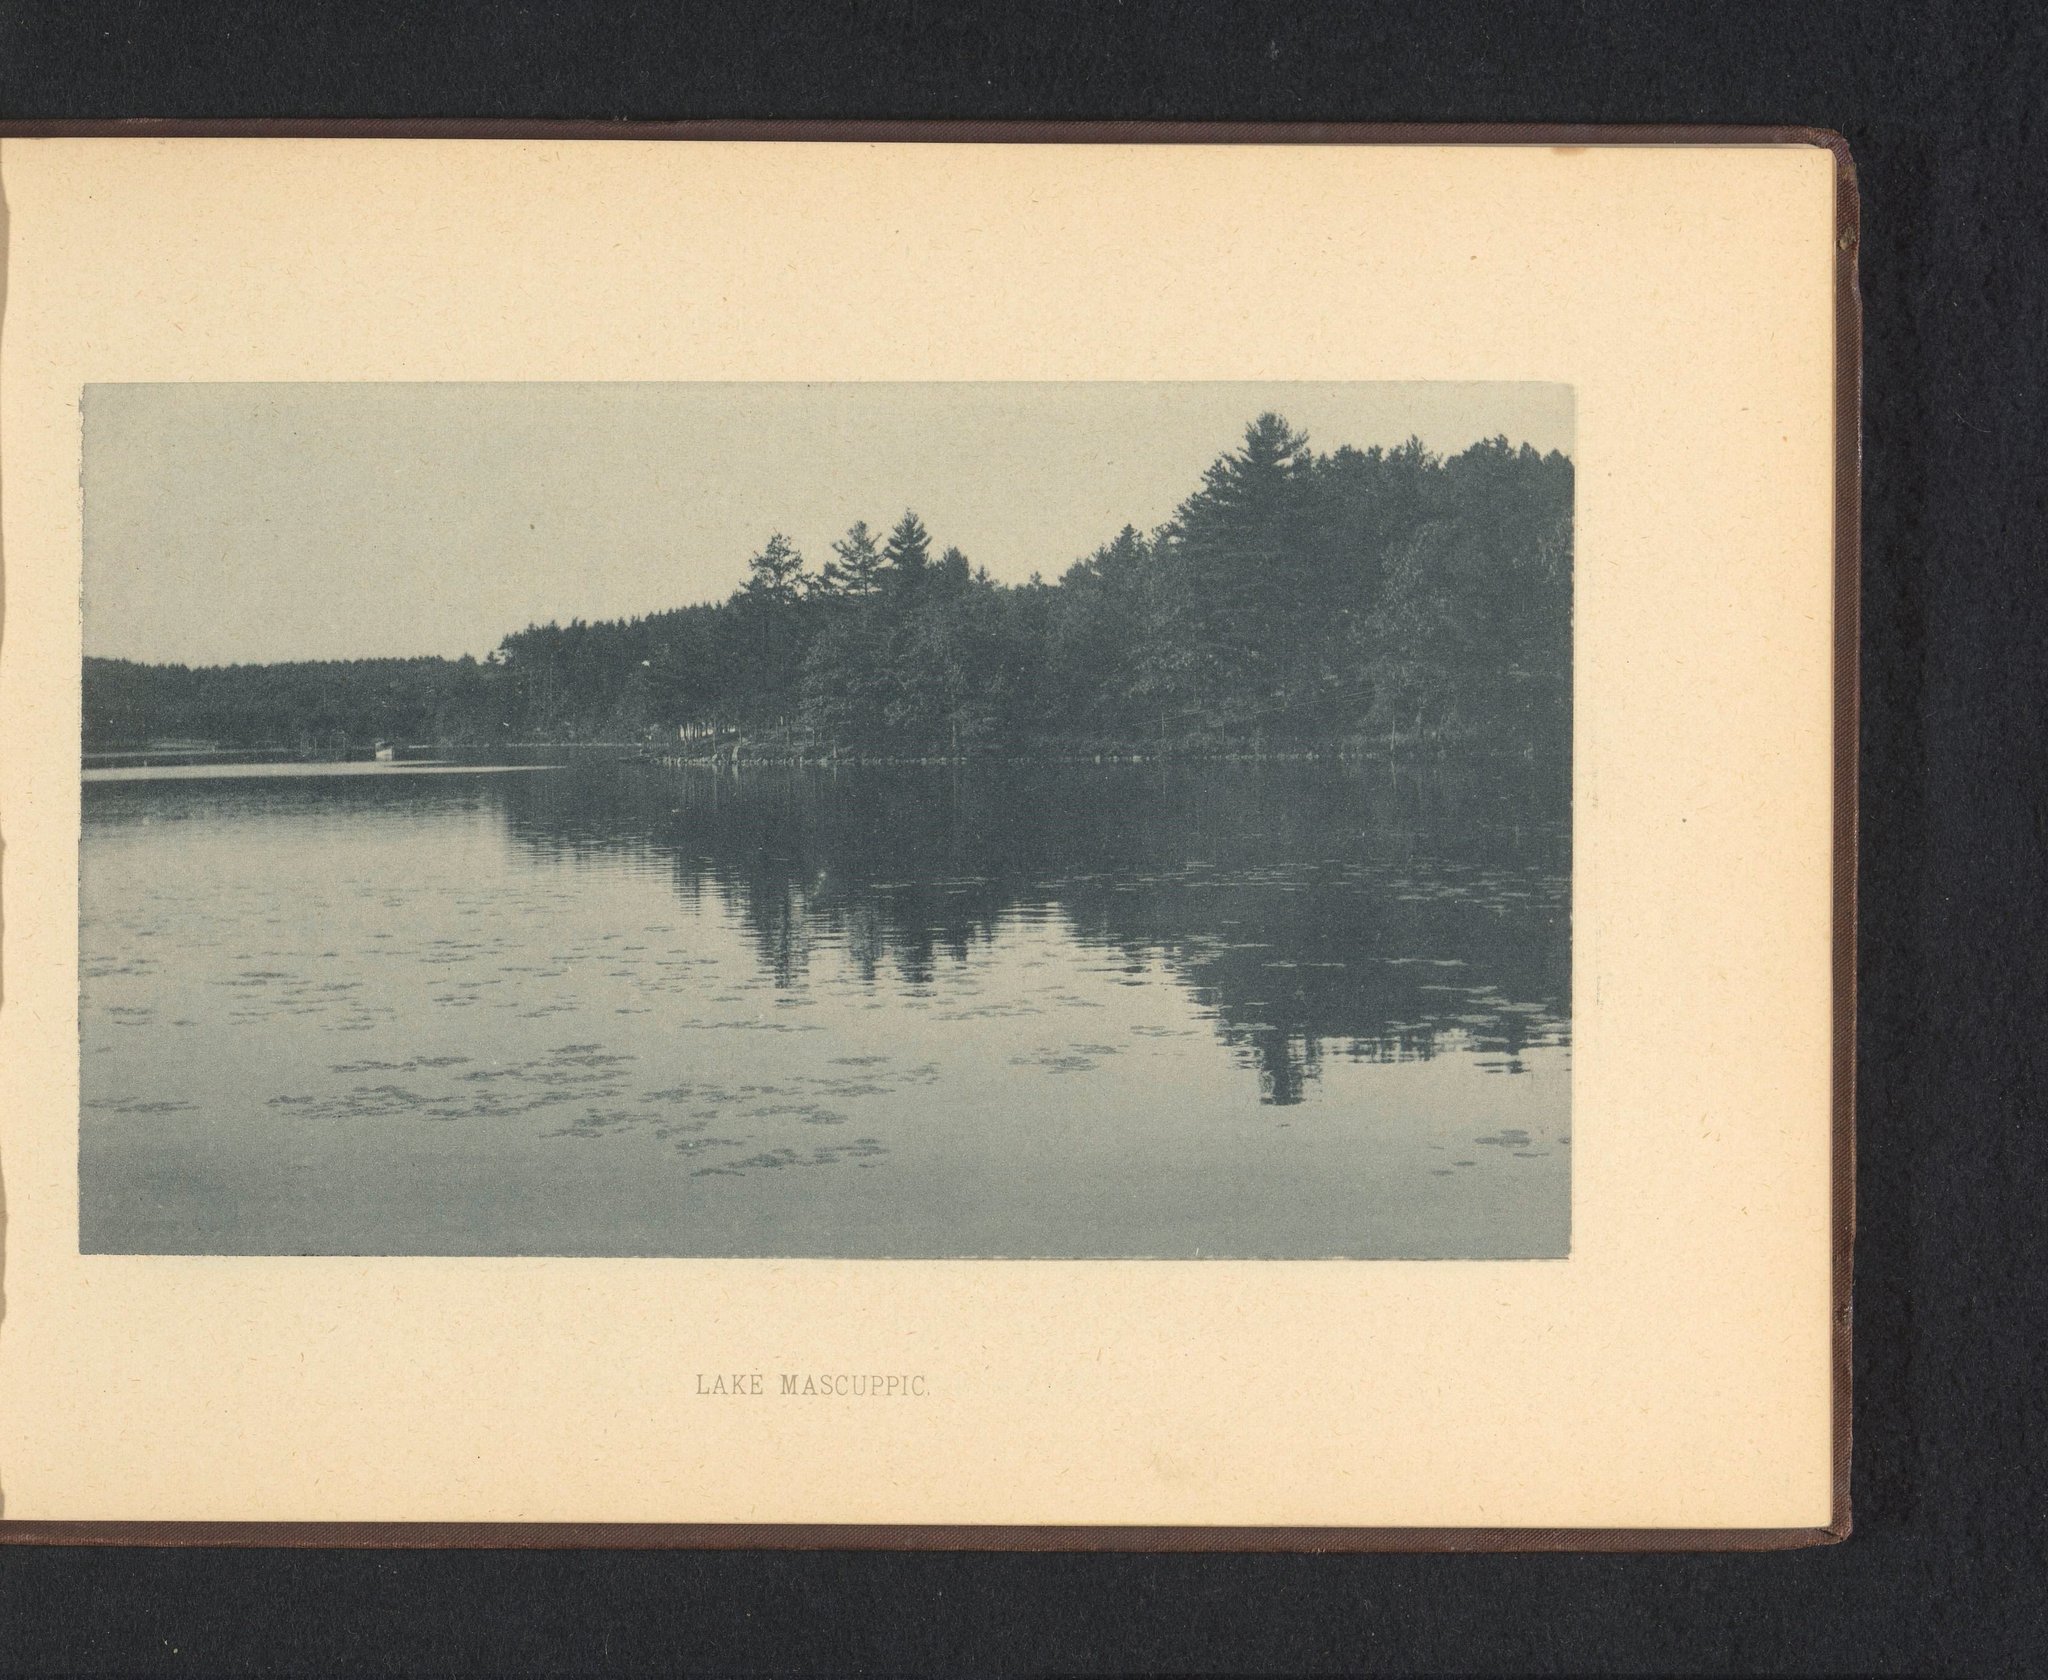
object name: page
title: Lake Mascuppic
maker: Anonymous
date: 1887-1892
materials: paper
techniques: photograph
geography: mascuppic lake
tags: gate, entrance, forest, wood, public gardens, park